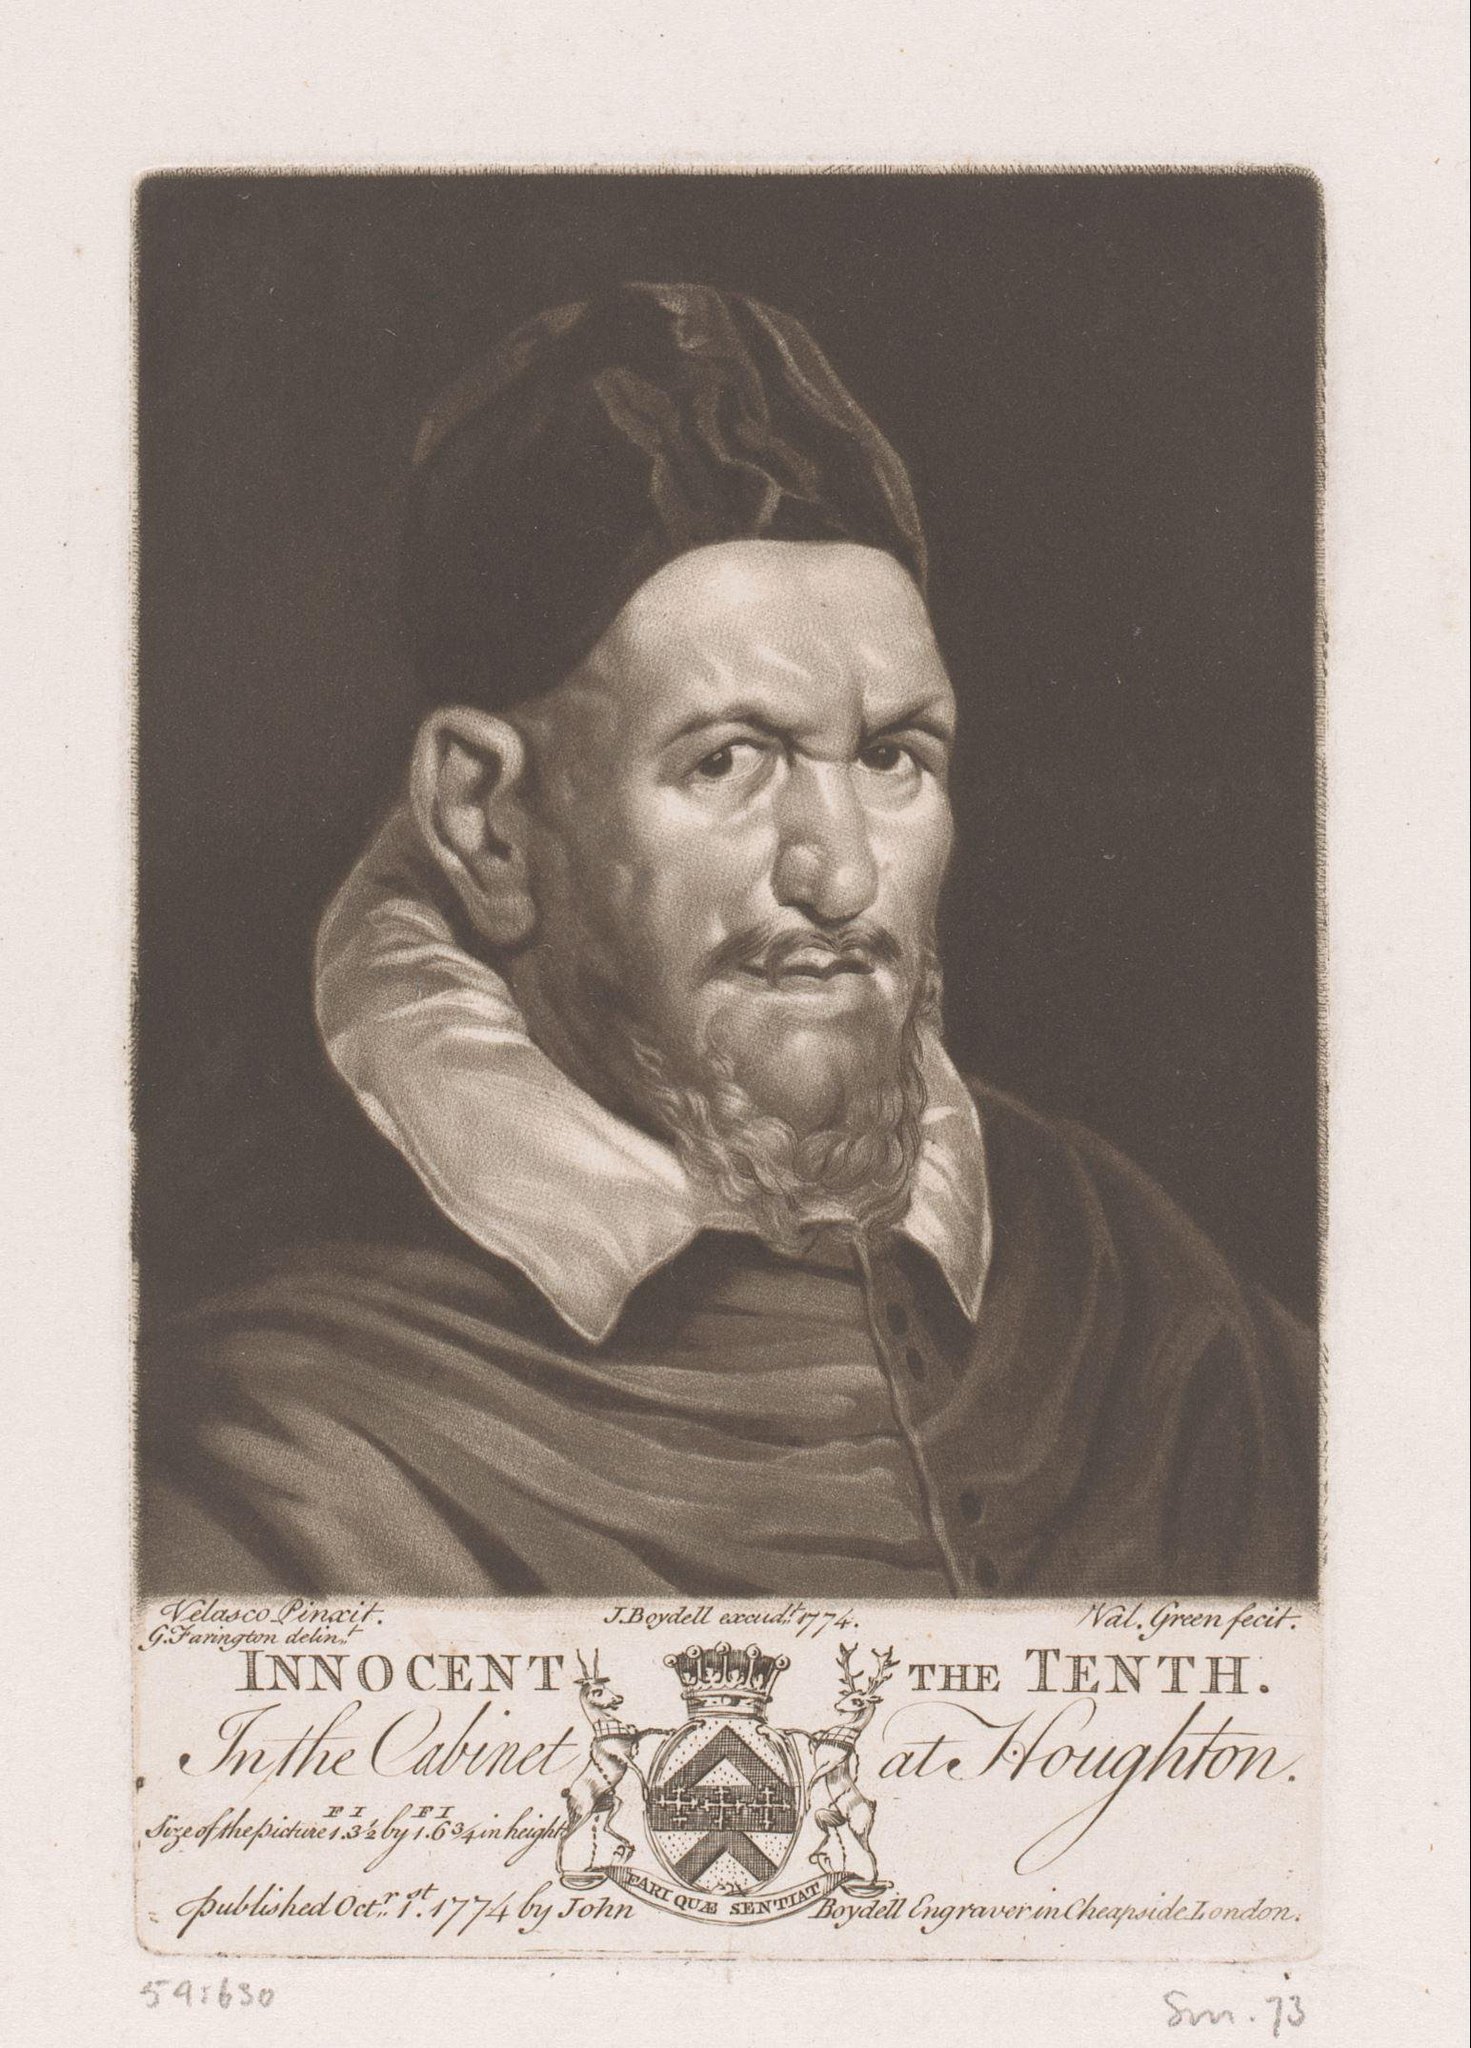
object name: print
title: Portret van paus Innocentius X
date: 1774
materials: paper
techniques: etching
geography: london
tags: rome, innocentius x, historical persons, pope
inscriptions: collector's mark: Lugt 2228, collector's mark: Lugt 2760